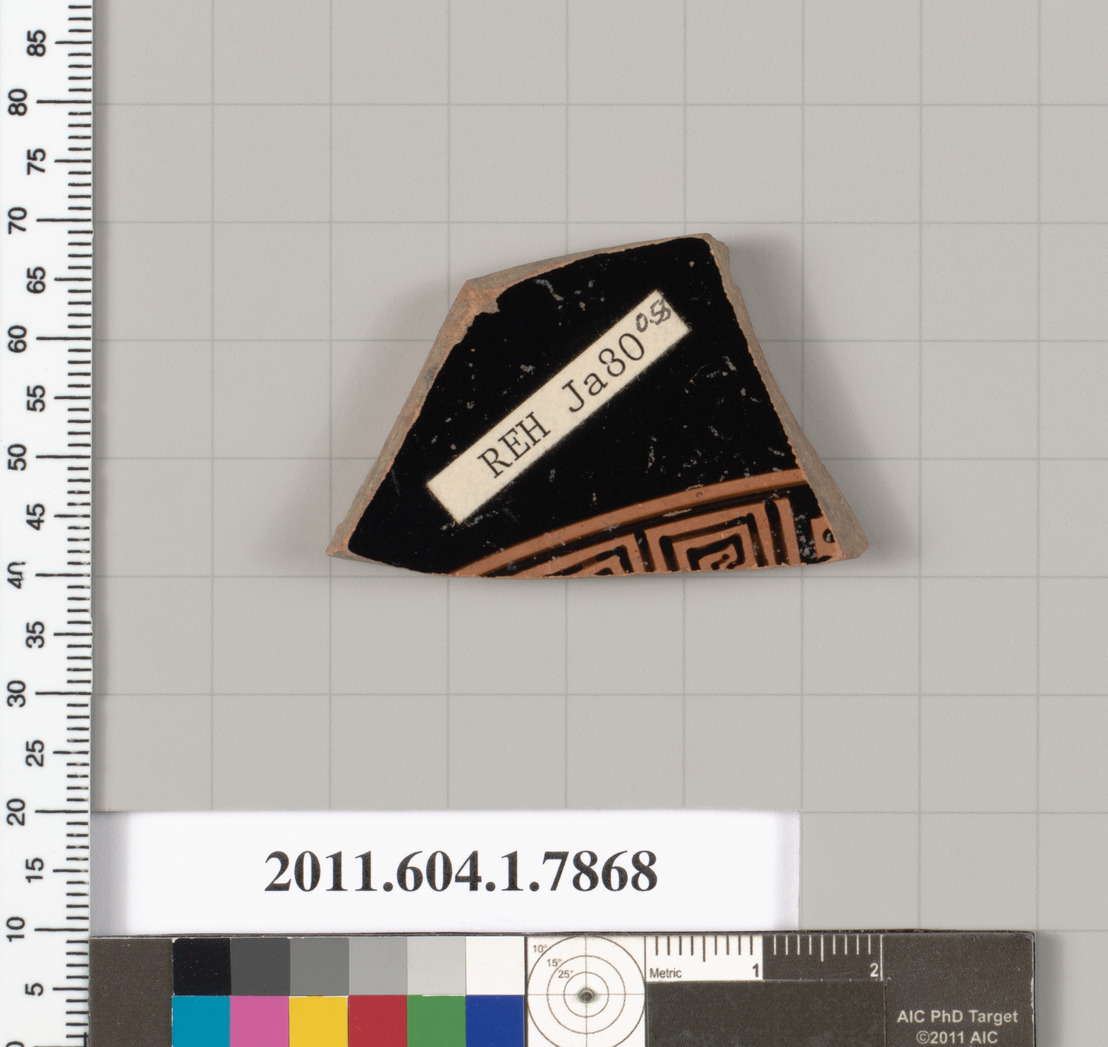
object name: kylix fragment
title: Terracotta fragment of a kylix (drinking cup)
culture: greek, attic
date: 440-420 BCE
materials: terracotta